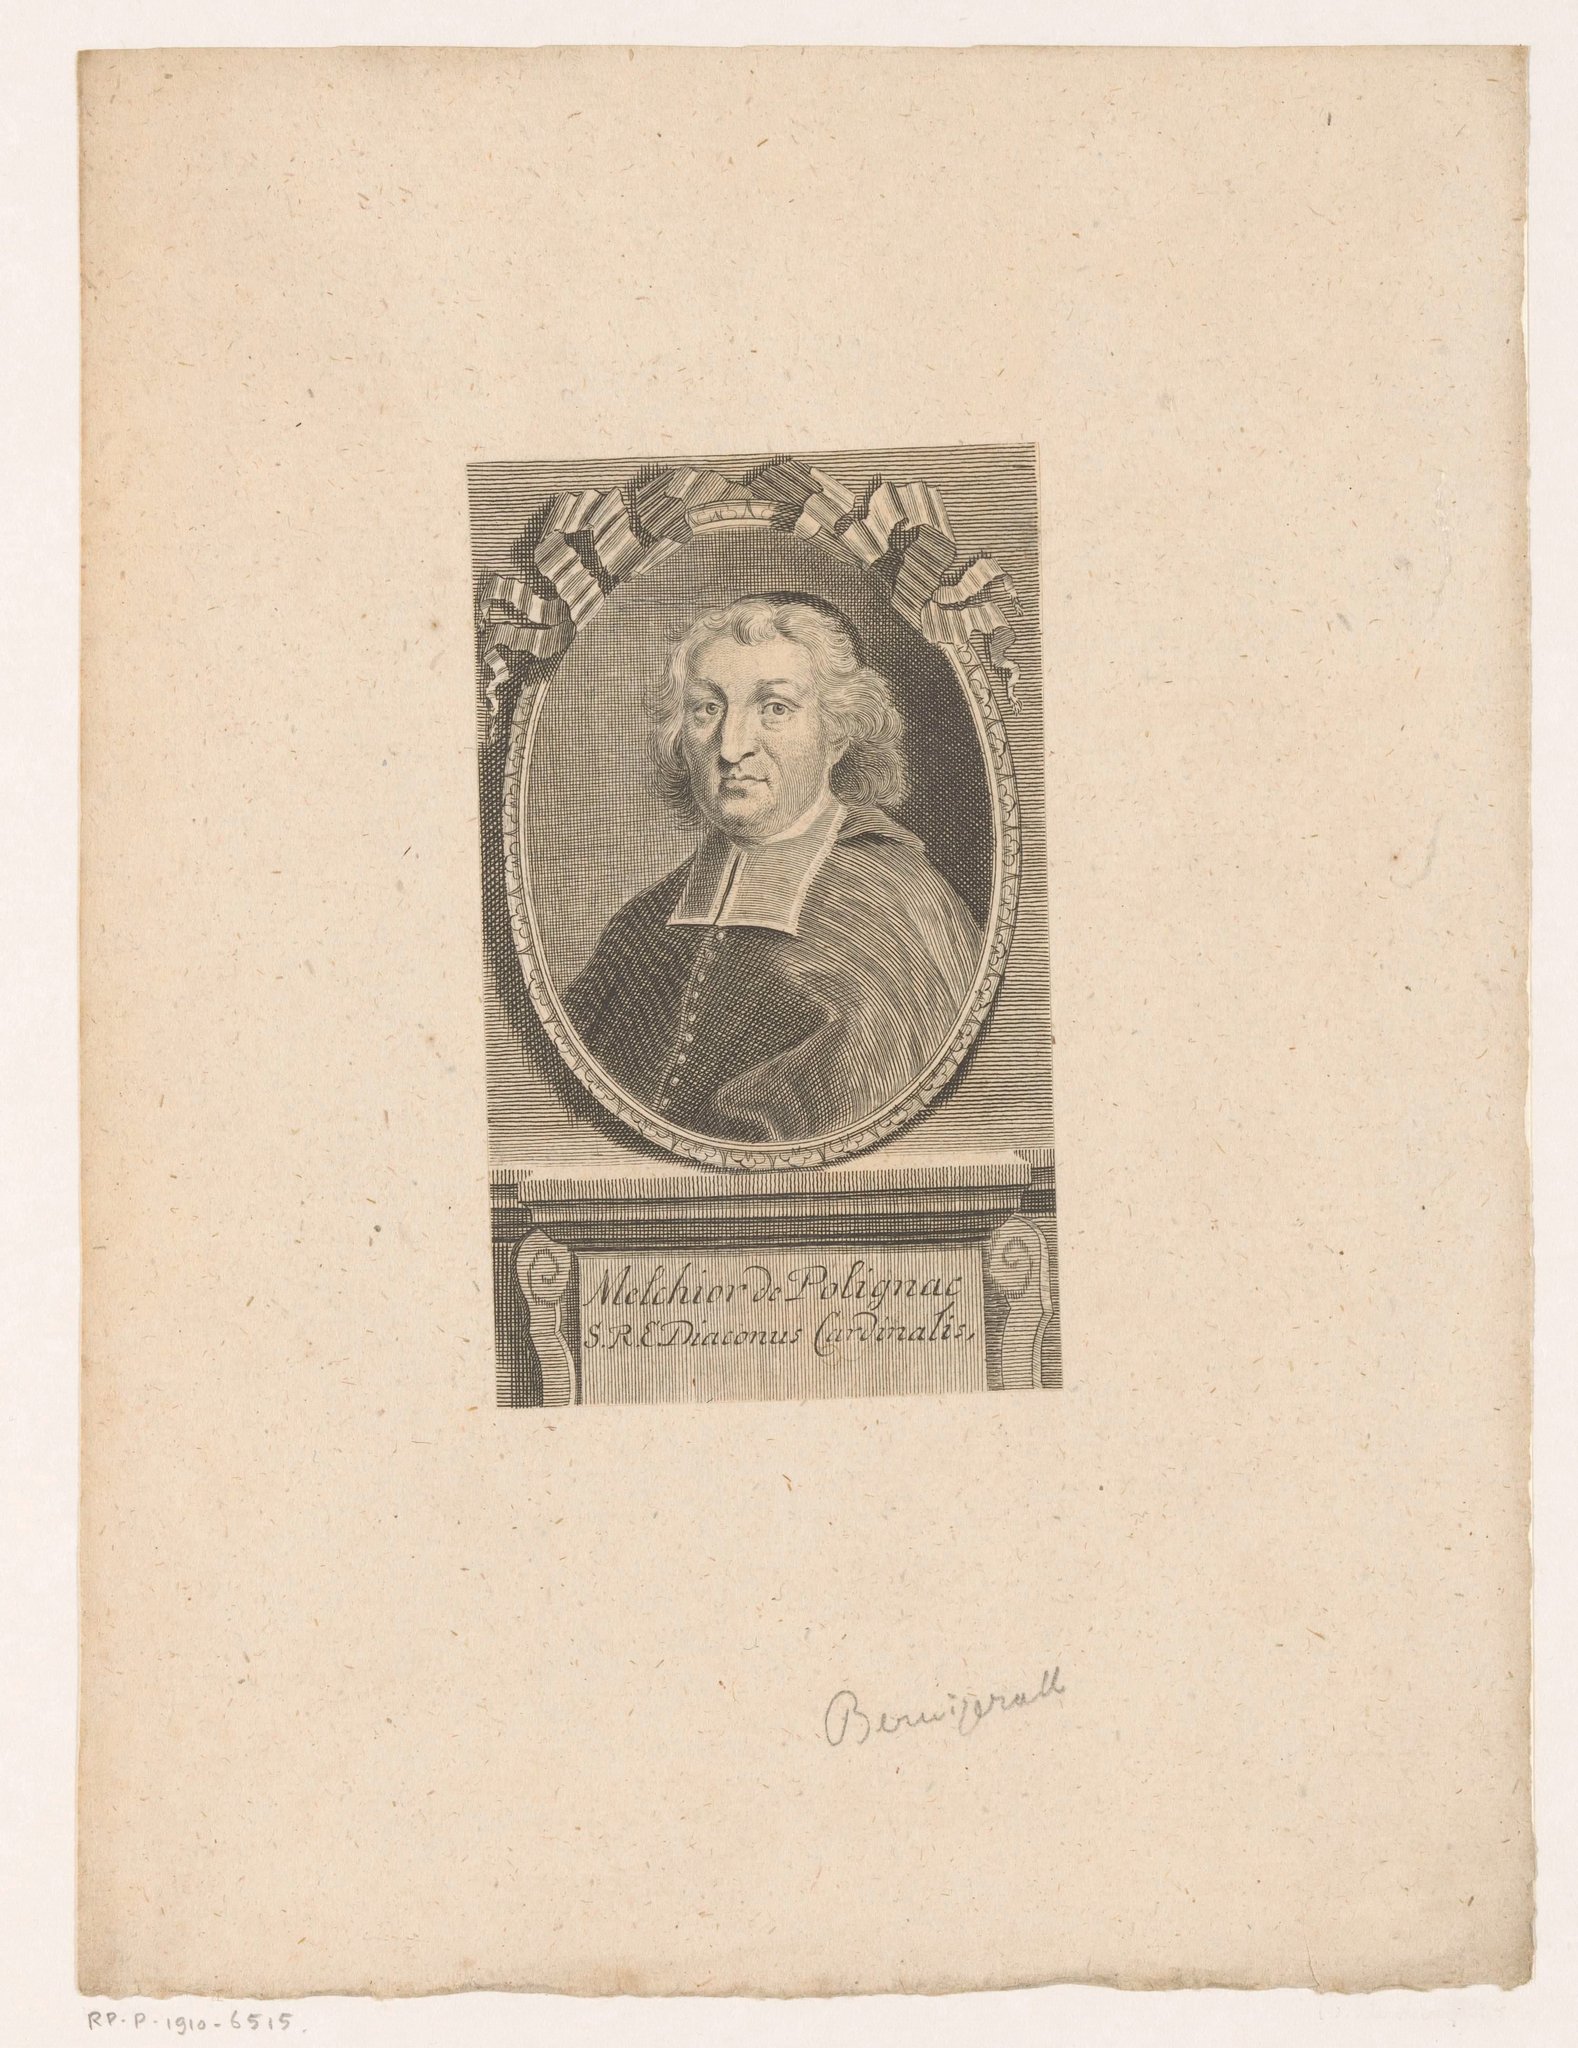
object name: print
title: Portret van Melchior de Polignac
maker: johann martin bernigeroth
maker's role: print maker, publisher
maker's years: 1713-1767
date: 1723-1767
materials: paper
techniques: engraving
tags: france, paris, melchior de polignac, historical persons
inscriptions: collector's mark: Lugt 2228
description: Prent ook gebruikt in: Die Europäische Fama, Welche den gegenwärtigen Zustand der vornehmsten Höfe entdecket. dl. 225. Leipzig: Gleditsch, 1719.